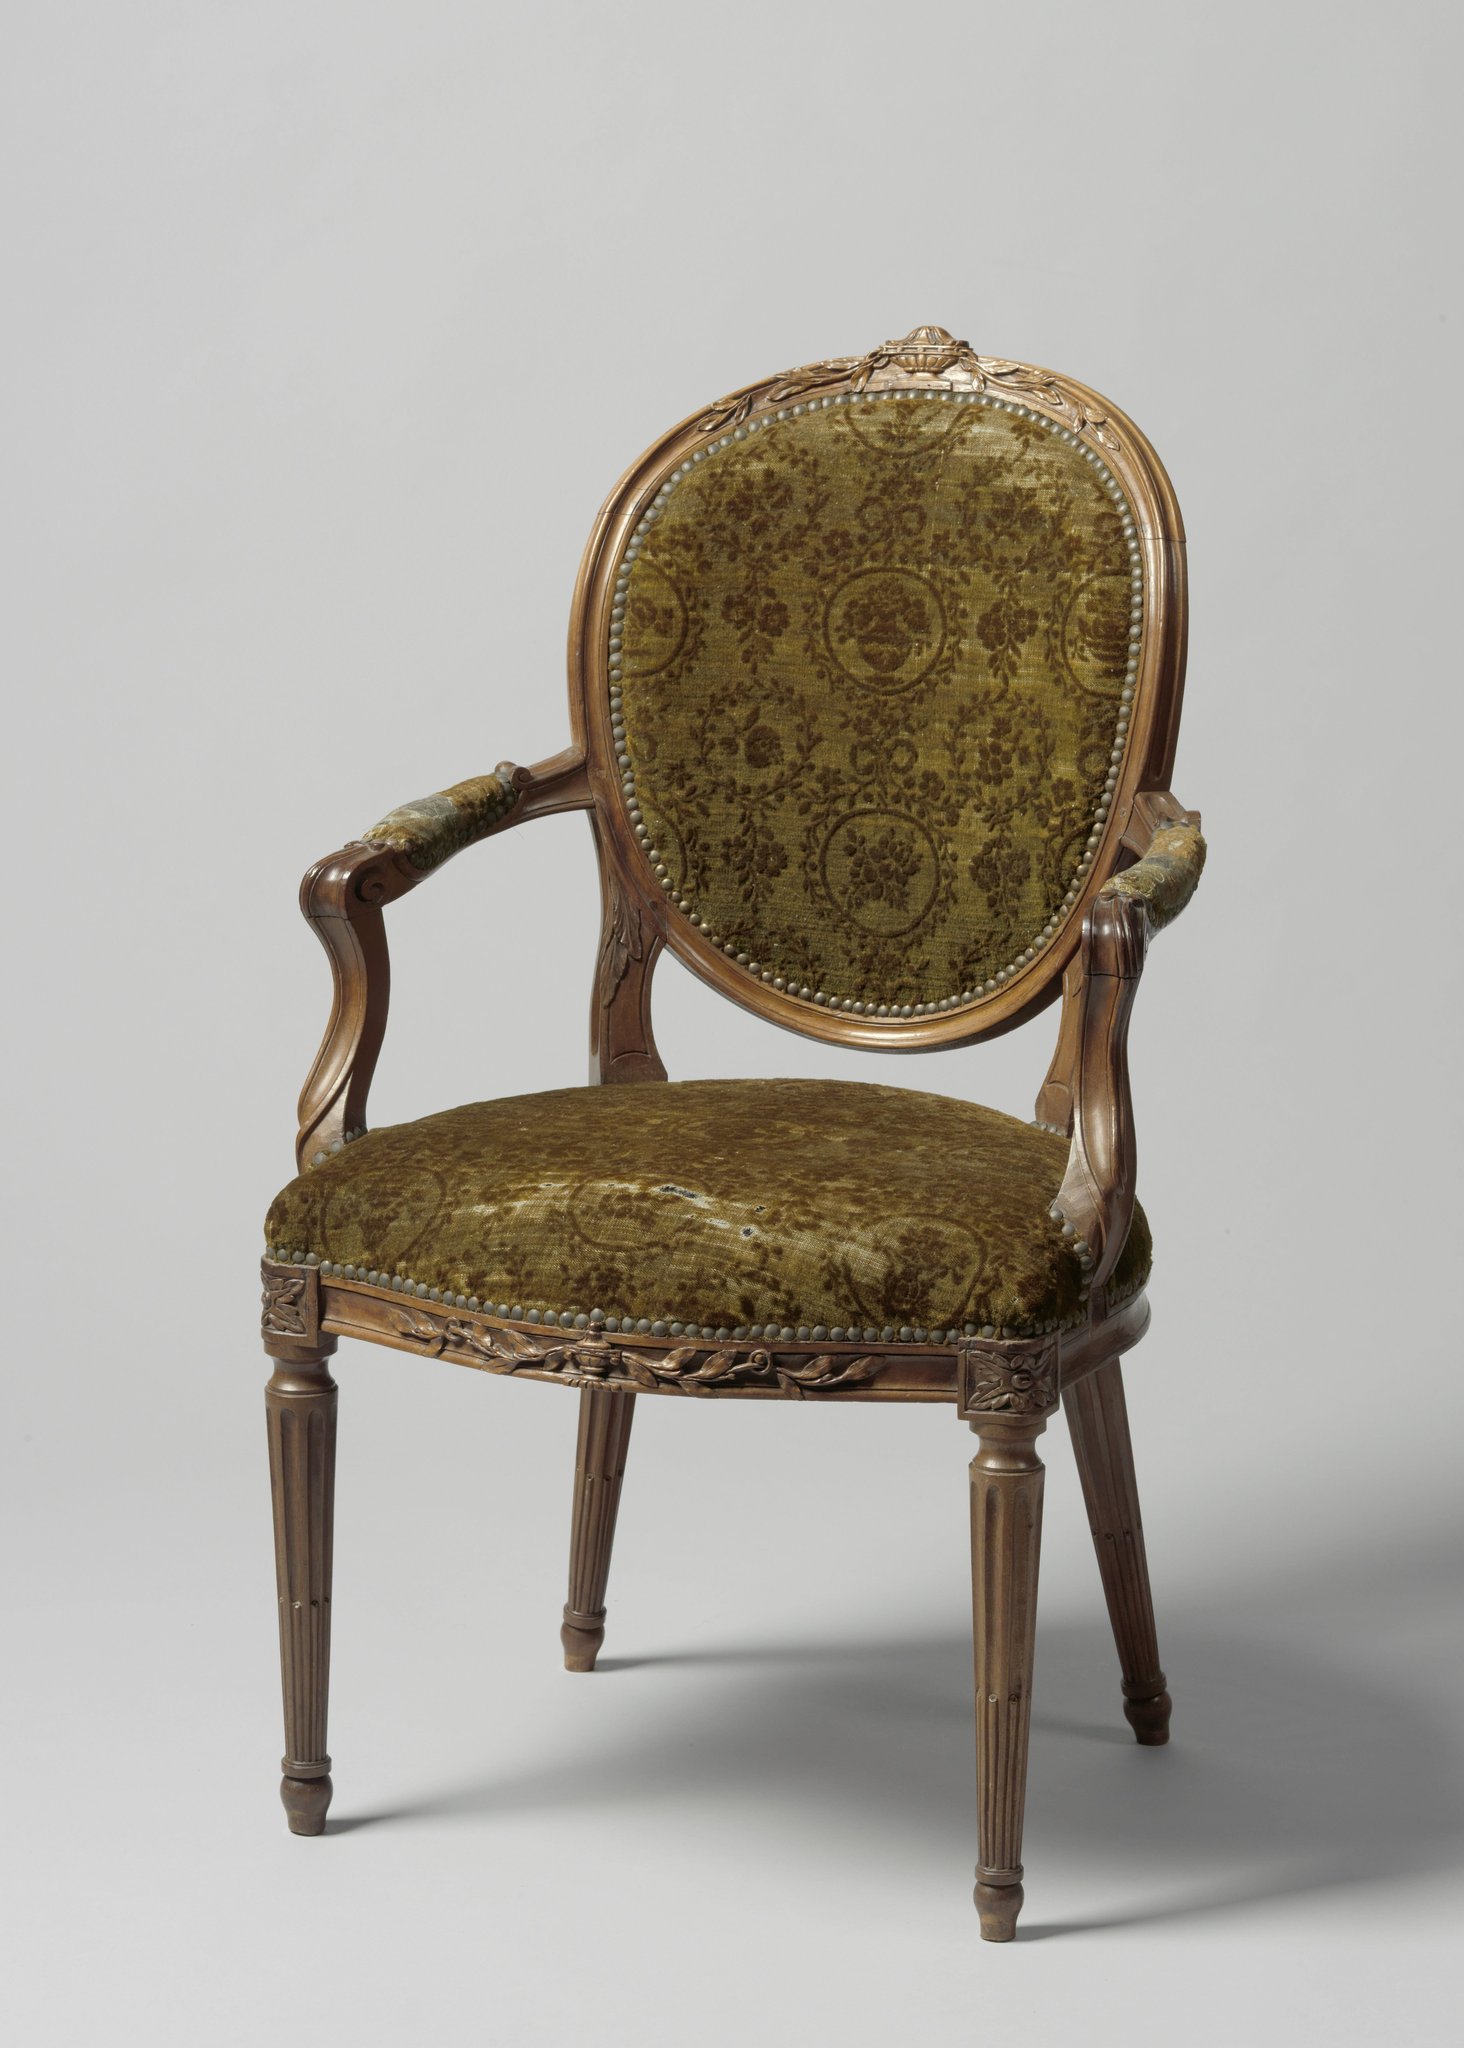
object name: chair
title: Stoel van mahoniehout, bekleed met groene trijp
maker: Anonymous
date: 1775-1800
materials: wood, textile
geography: northern netherlands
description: Armchair. Mahogany, the velvet upholstery has been renewed. Netherlands, c. 1780 - 1800. Given by Mr and Mrs Drucker-Fraser, 1922.